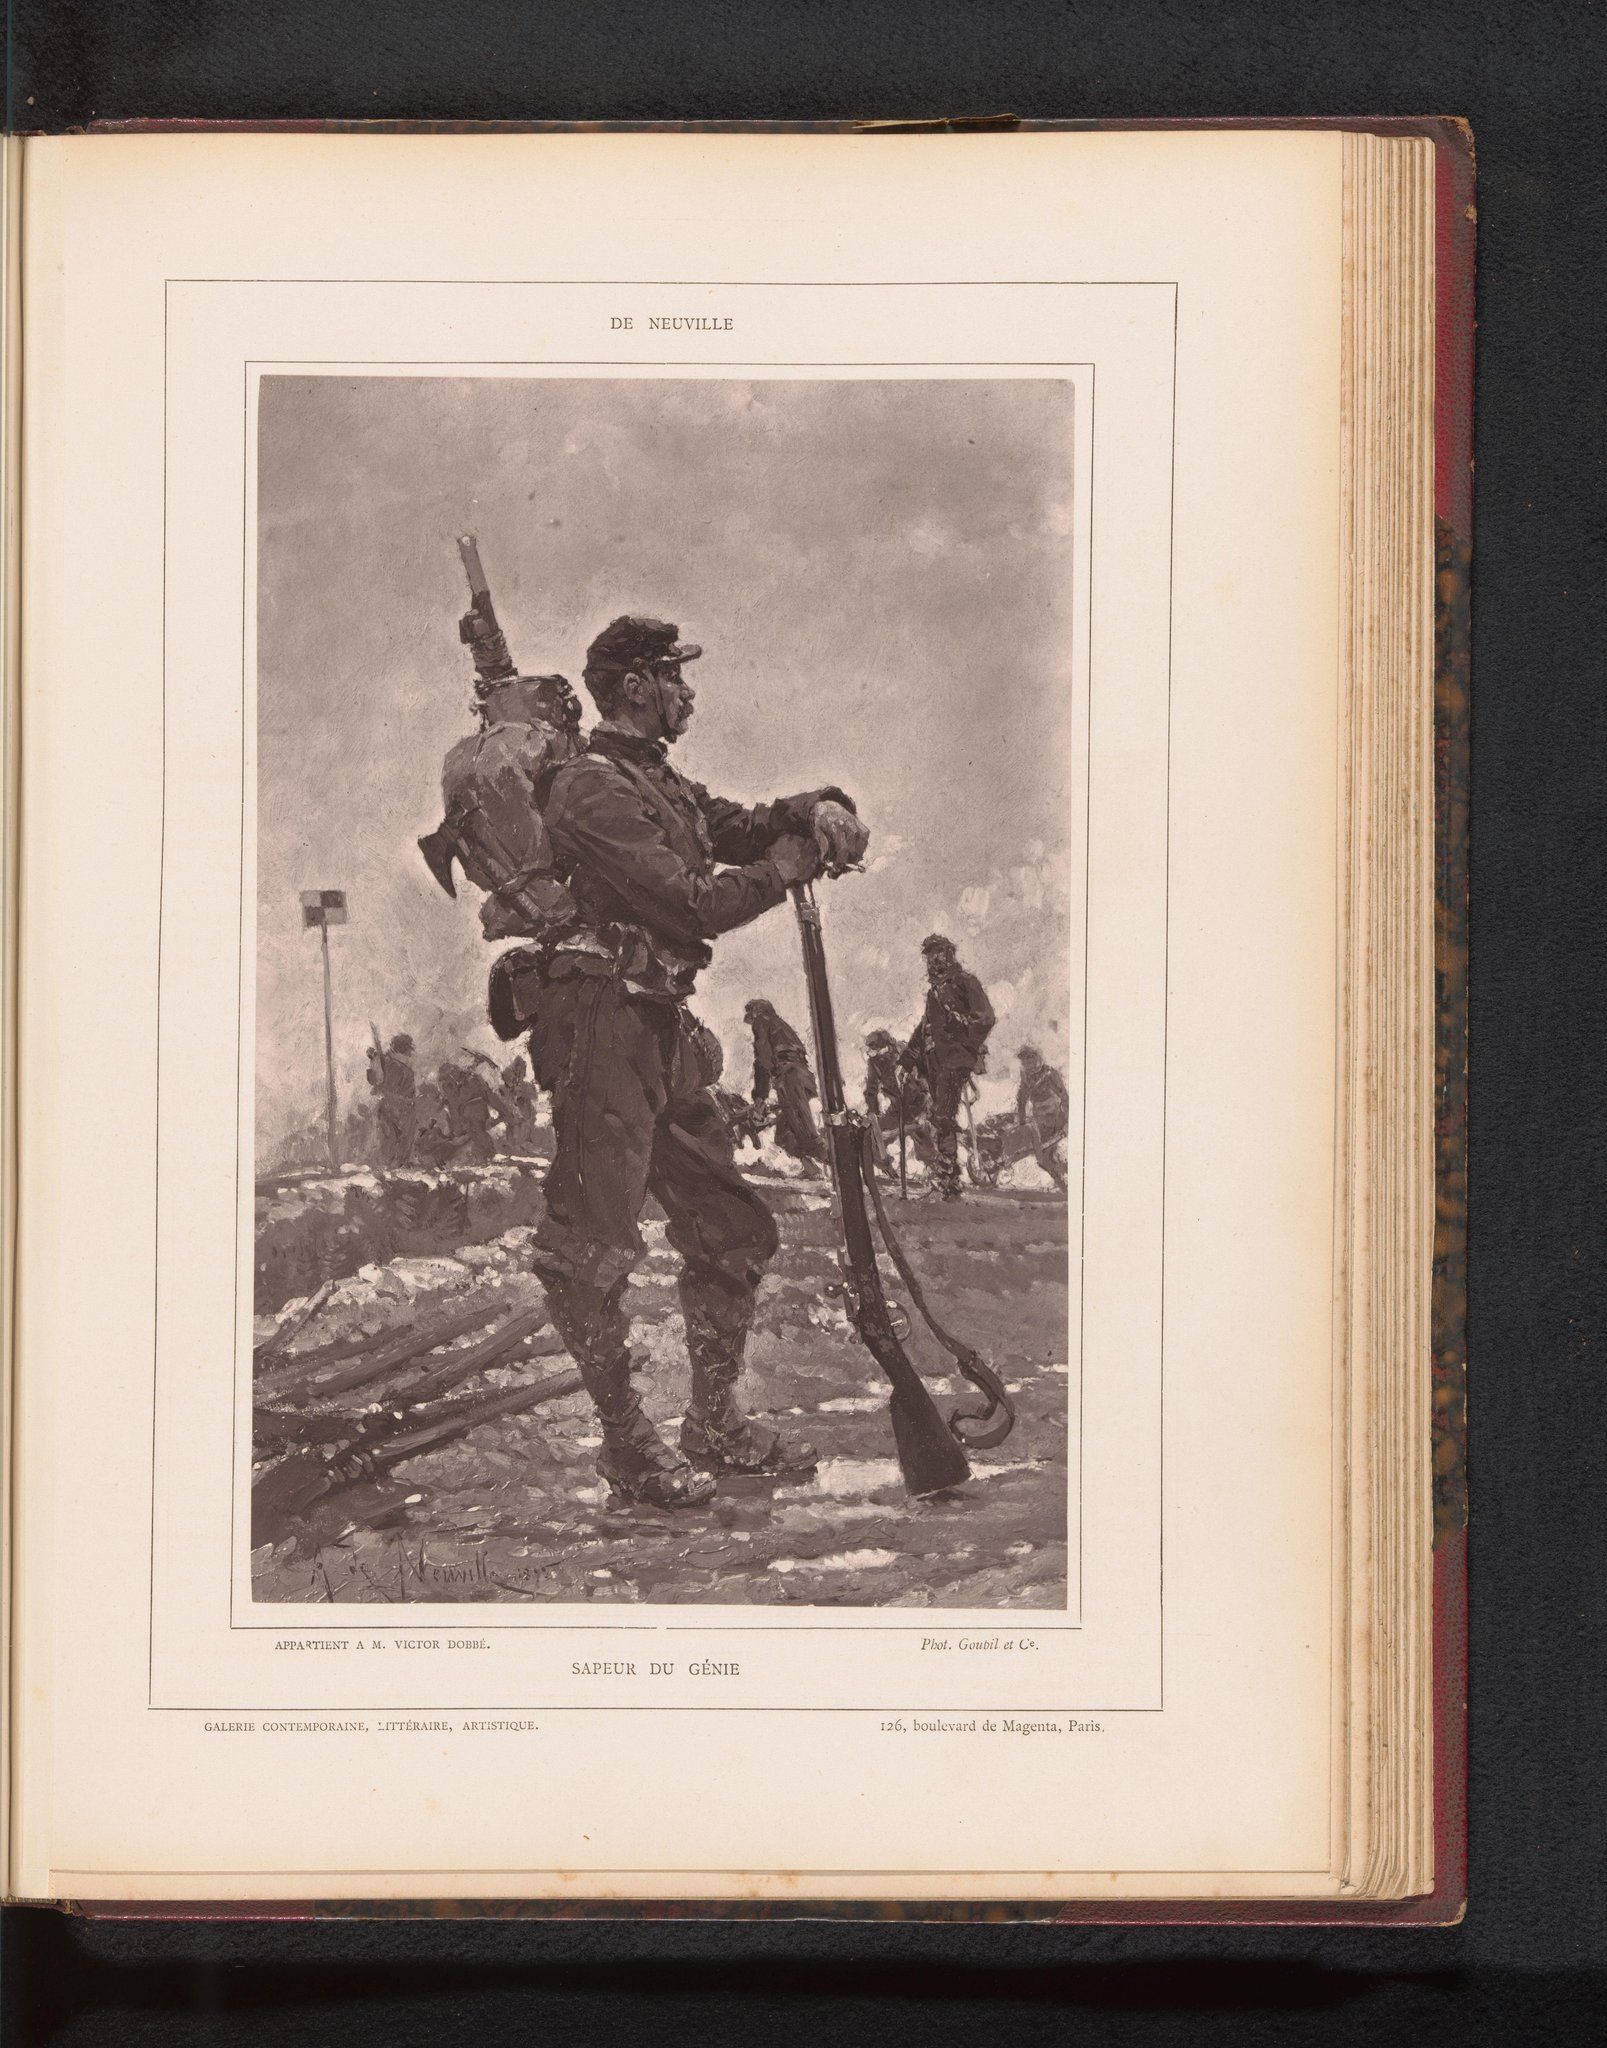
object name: page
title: Sapeur du génie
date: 1871-1876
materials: paper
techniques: woodburytype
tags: the soldier; the soldier's life, painting, drawing and the graphic arts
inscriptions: inscription: ‘De Neuville/ Appartient a M. Victor Dobbé. / Galerie Contemporaine, Littéraire et Artistique/ 126, boulevard de Magenta, Paris.’